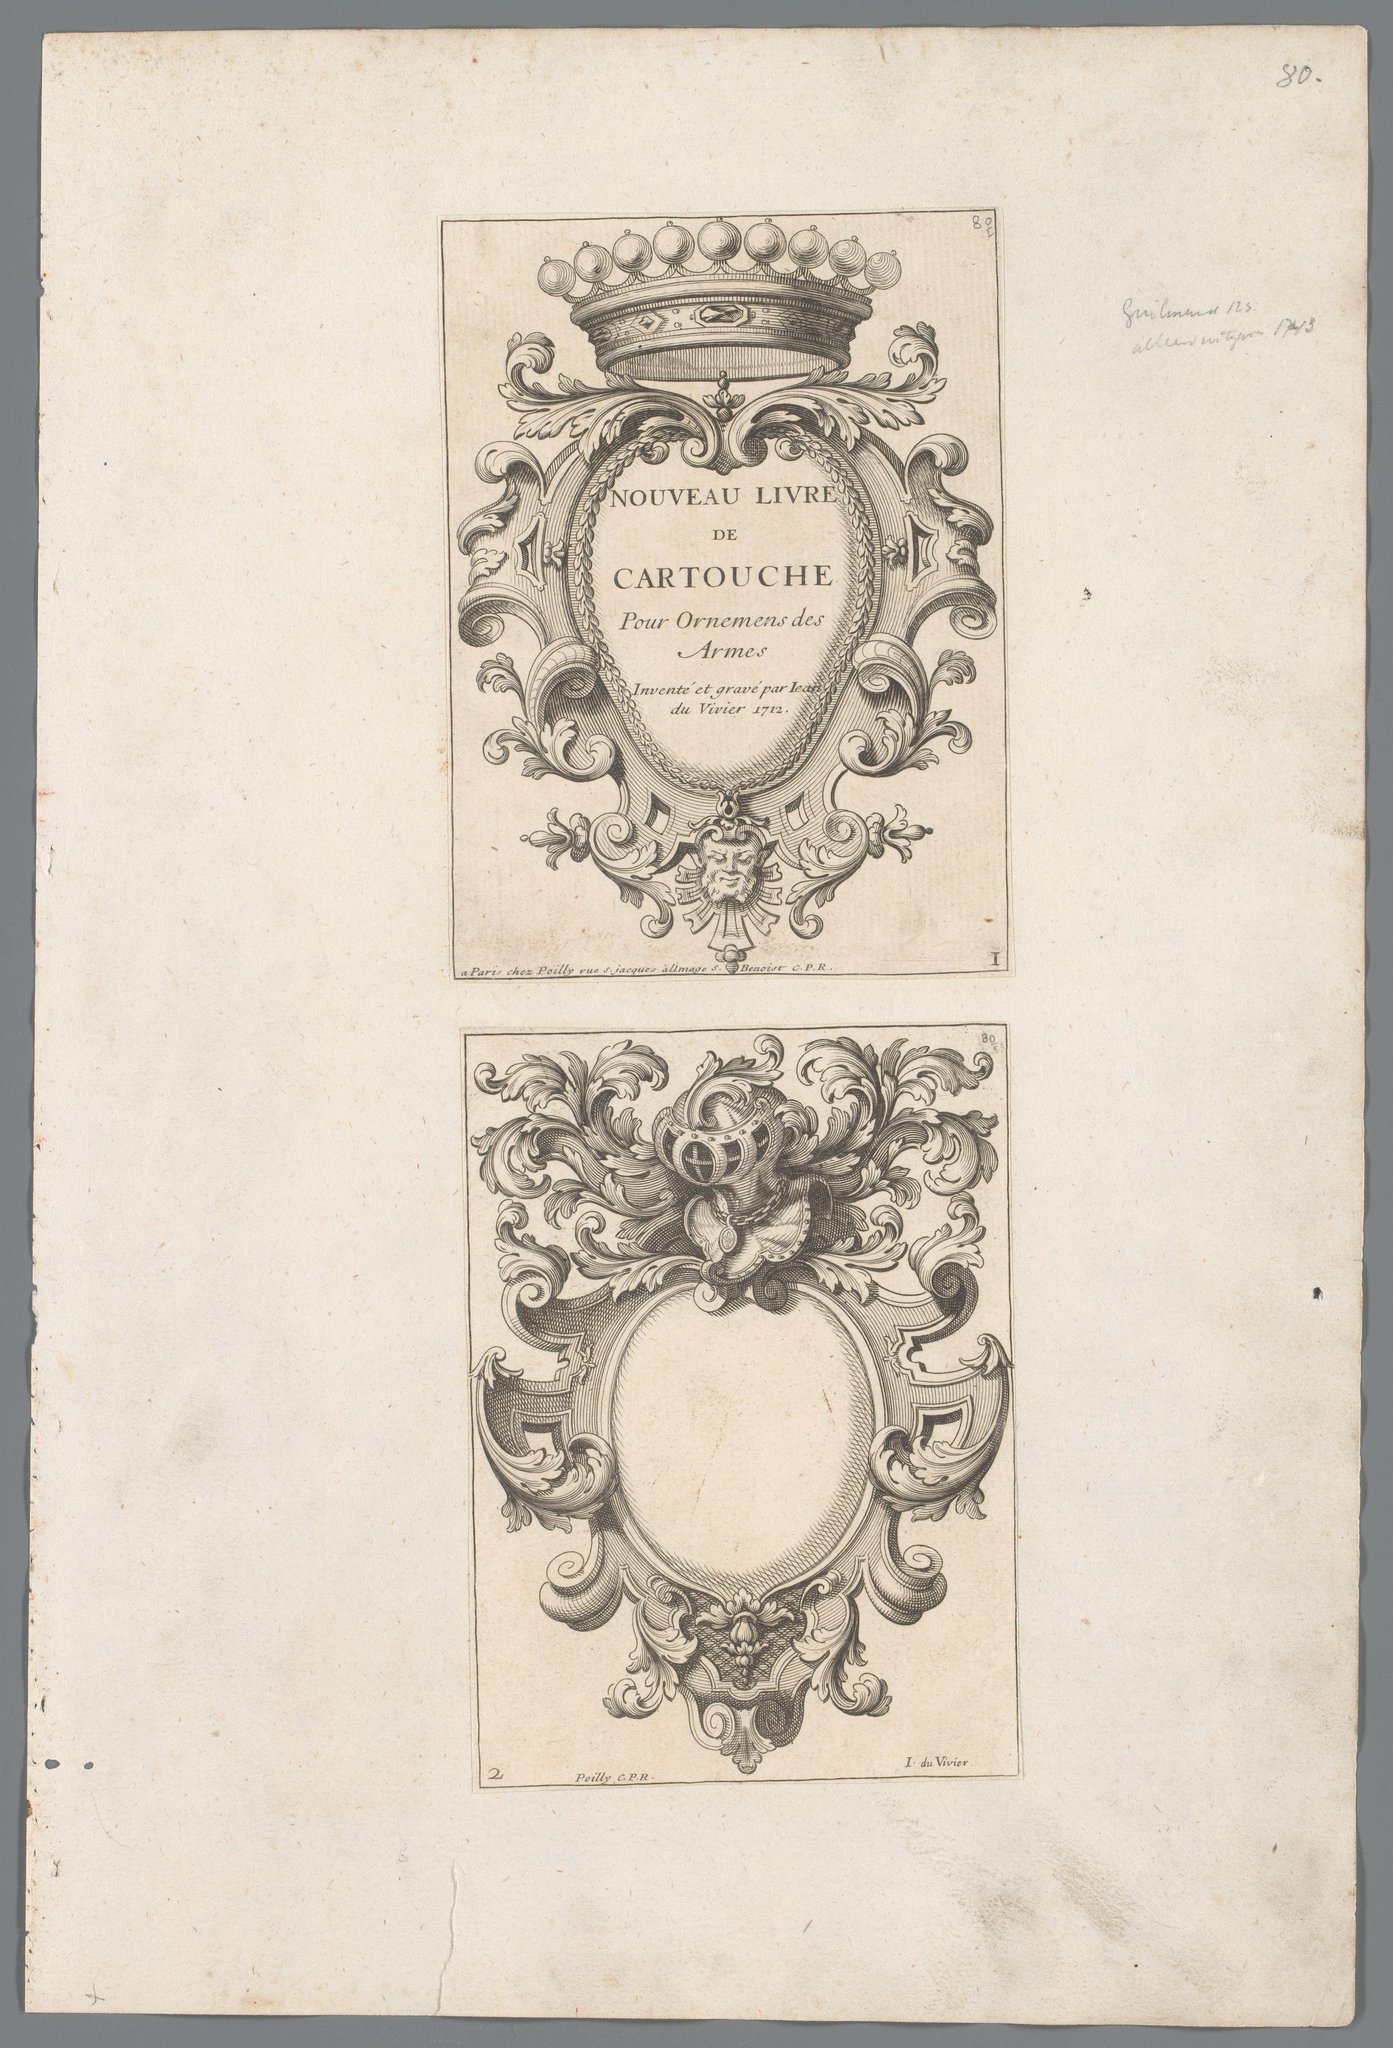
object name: ornament print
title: Cartouche met een helm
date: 1712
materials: paper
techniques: engraving, etching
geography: paris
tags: helmet, ornament ~ cartouche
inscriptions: collector's mark: Lugt 2760, collector's mark: Lugt 2228